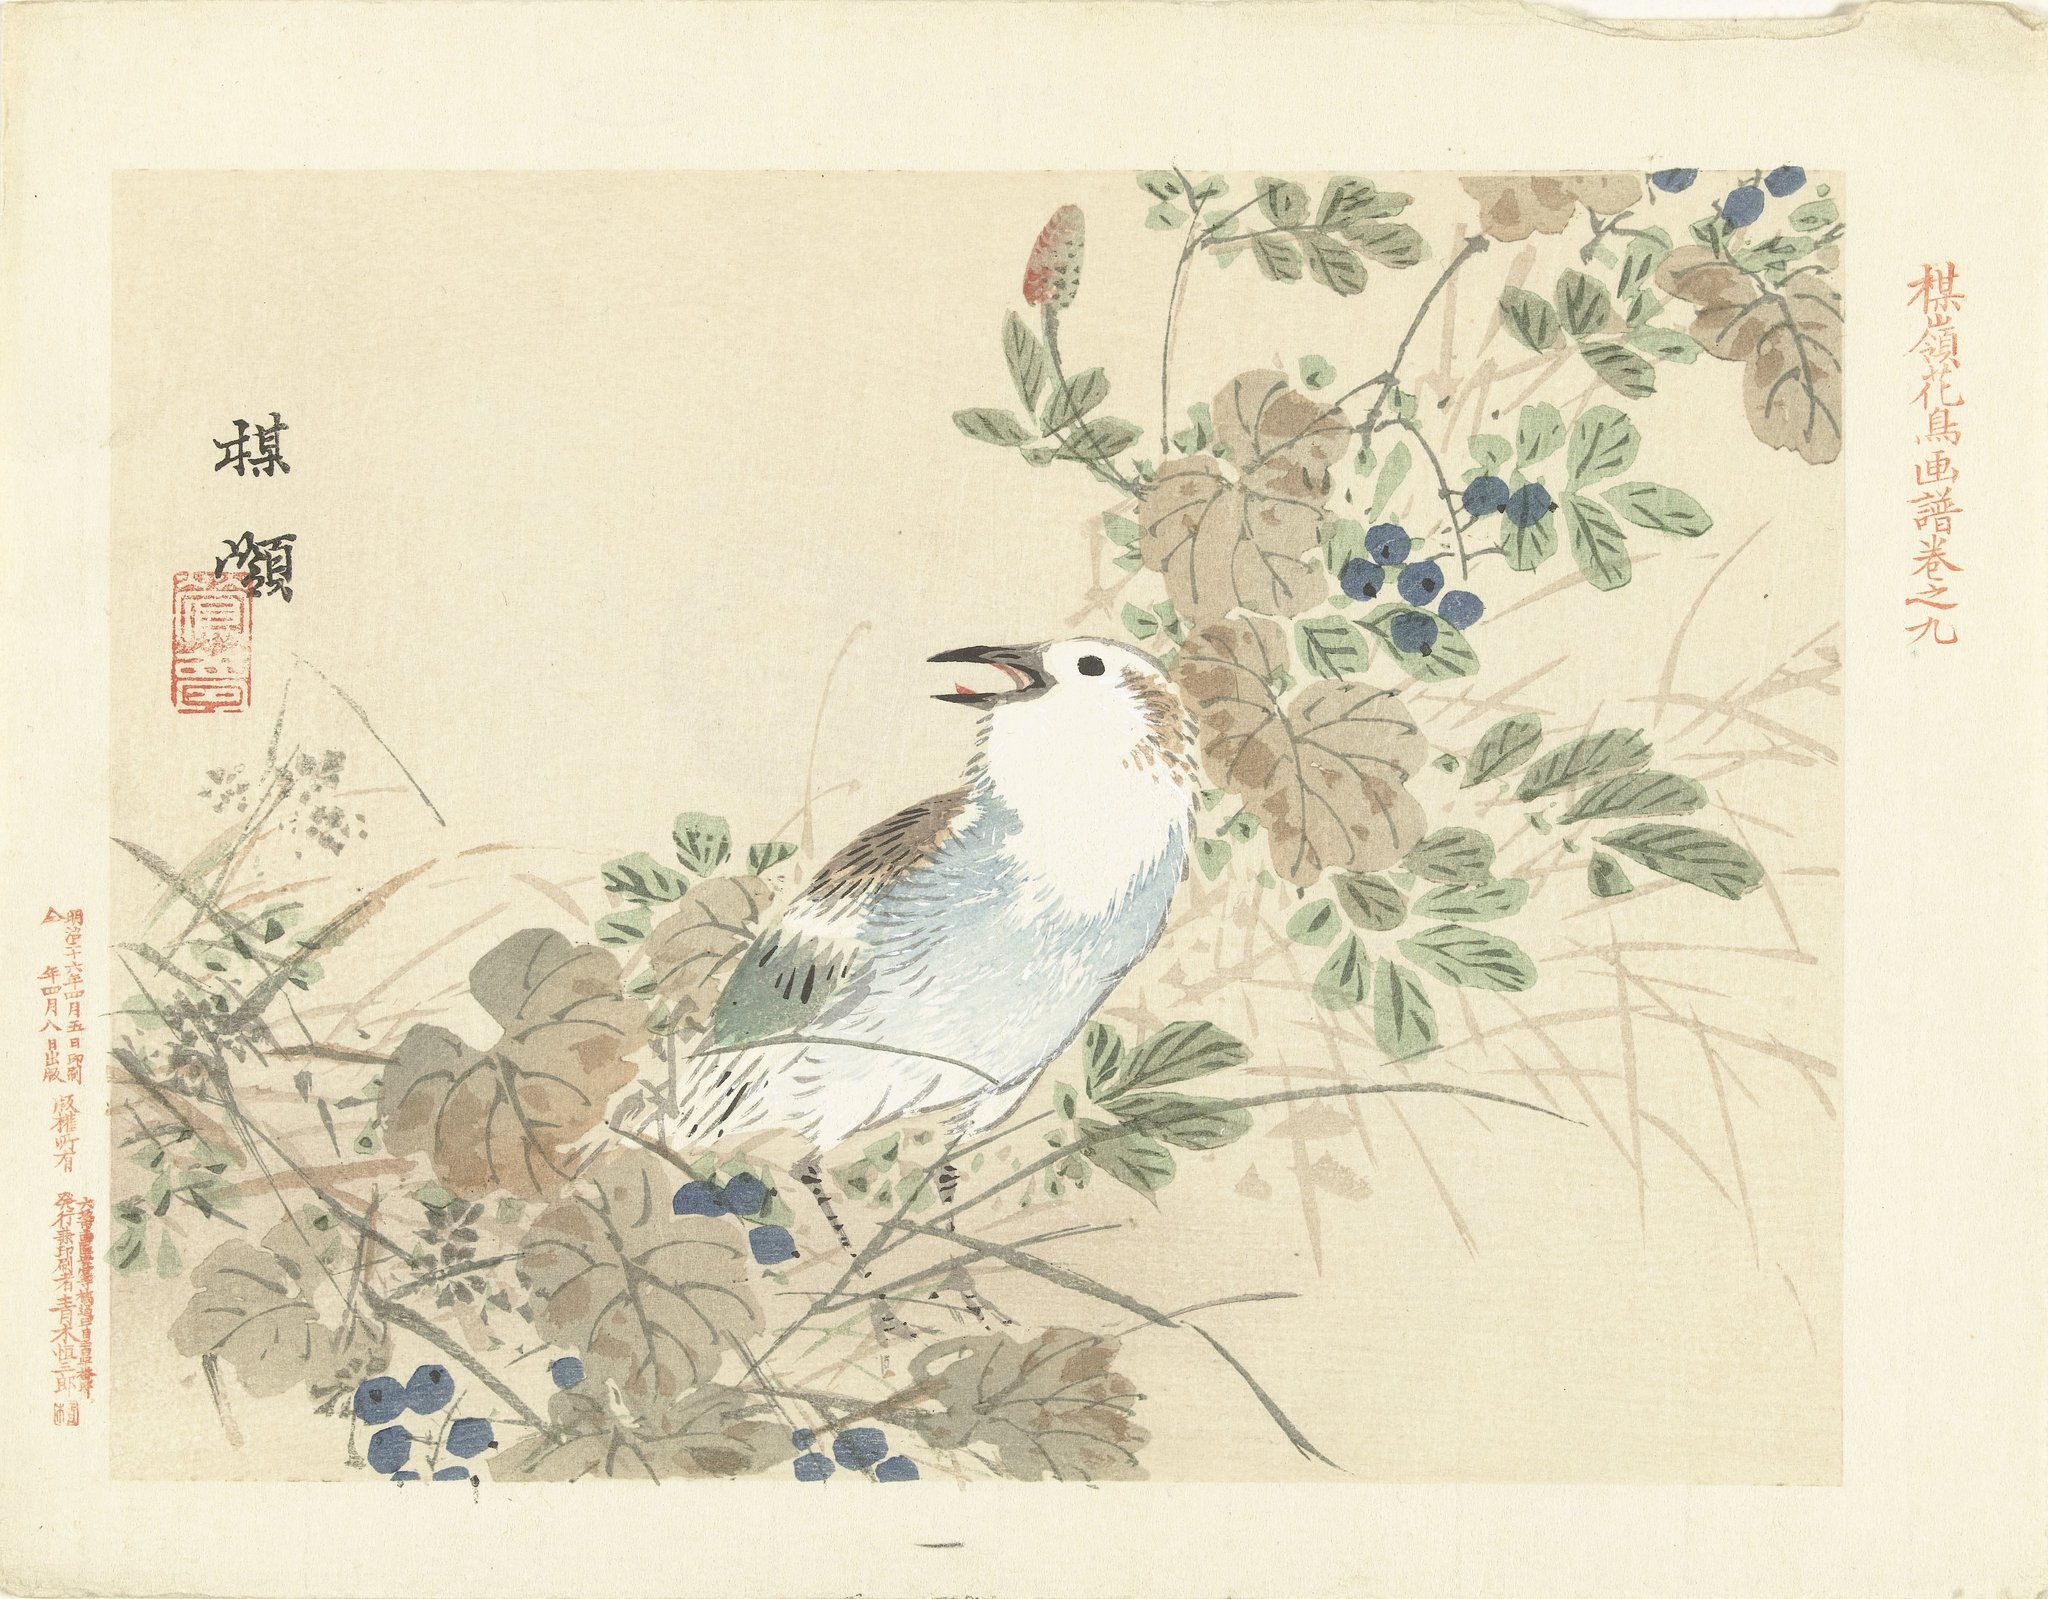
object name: print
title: Zangvogel tussen herfstgrassen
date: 1804-1893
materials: paper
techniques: woodcut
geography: osaka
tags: plants; vegetation, birds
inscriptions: collector's mark: ‘Rijksschool voor kunstnijverheid’ Lugt 3937, collector's mark: Lugt 2228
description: Vogel met witte kop en blauwe borst, tussen struik met blauwe bessen.